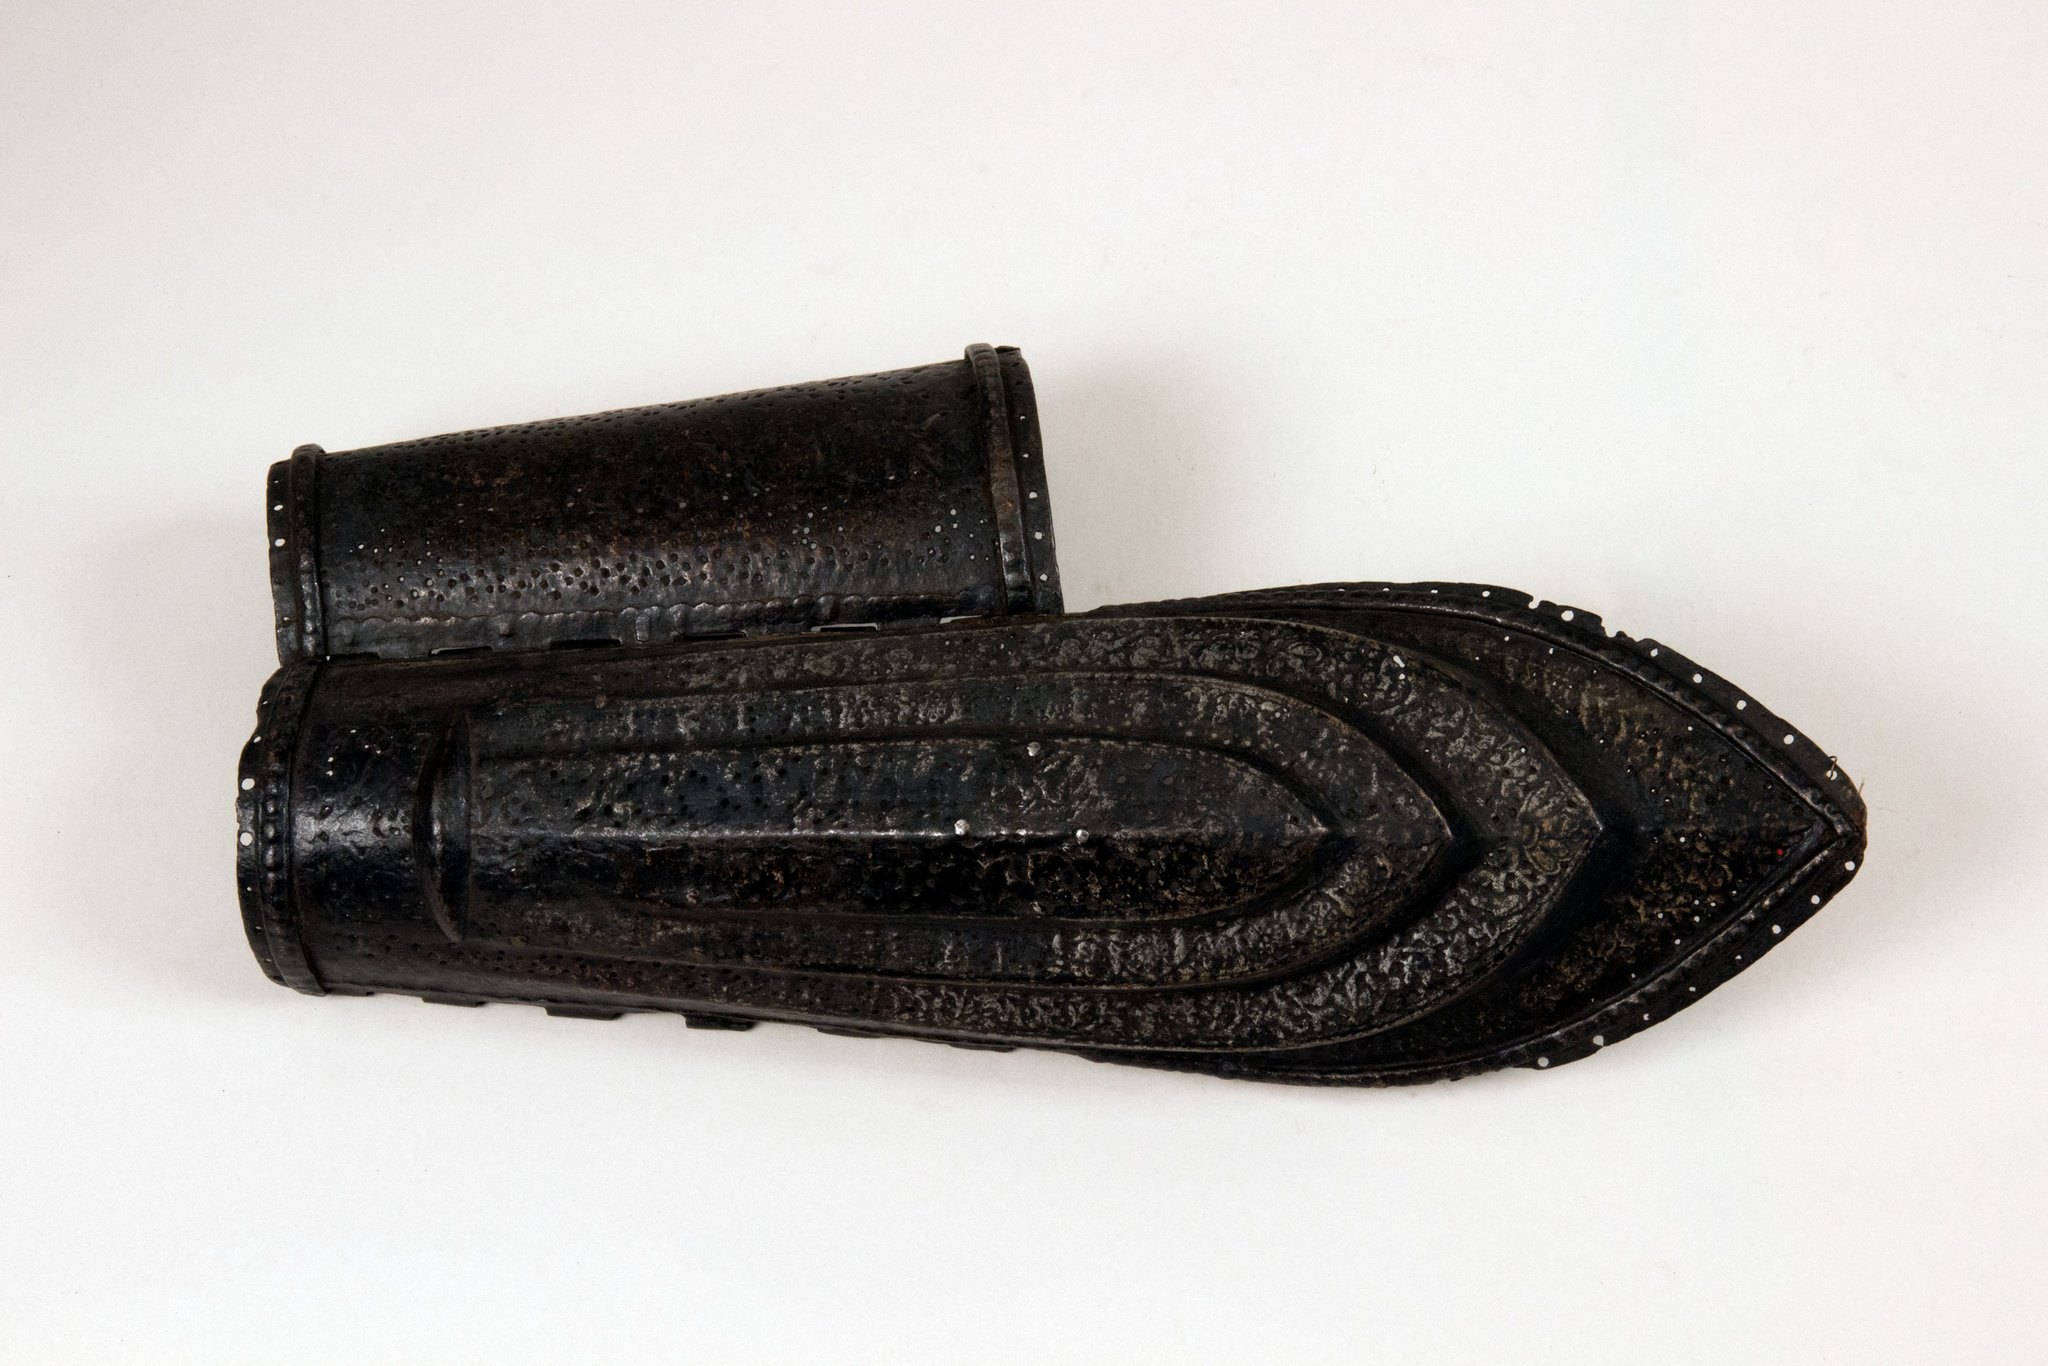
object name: arm guard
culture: indian, thanjavur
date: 1601-1700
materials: silver, steel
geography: india